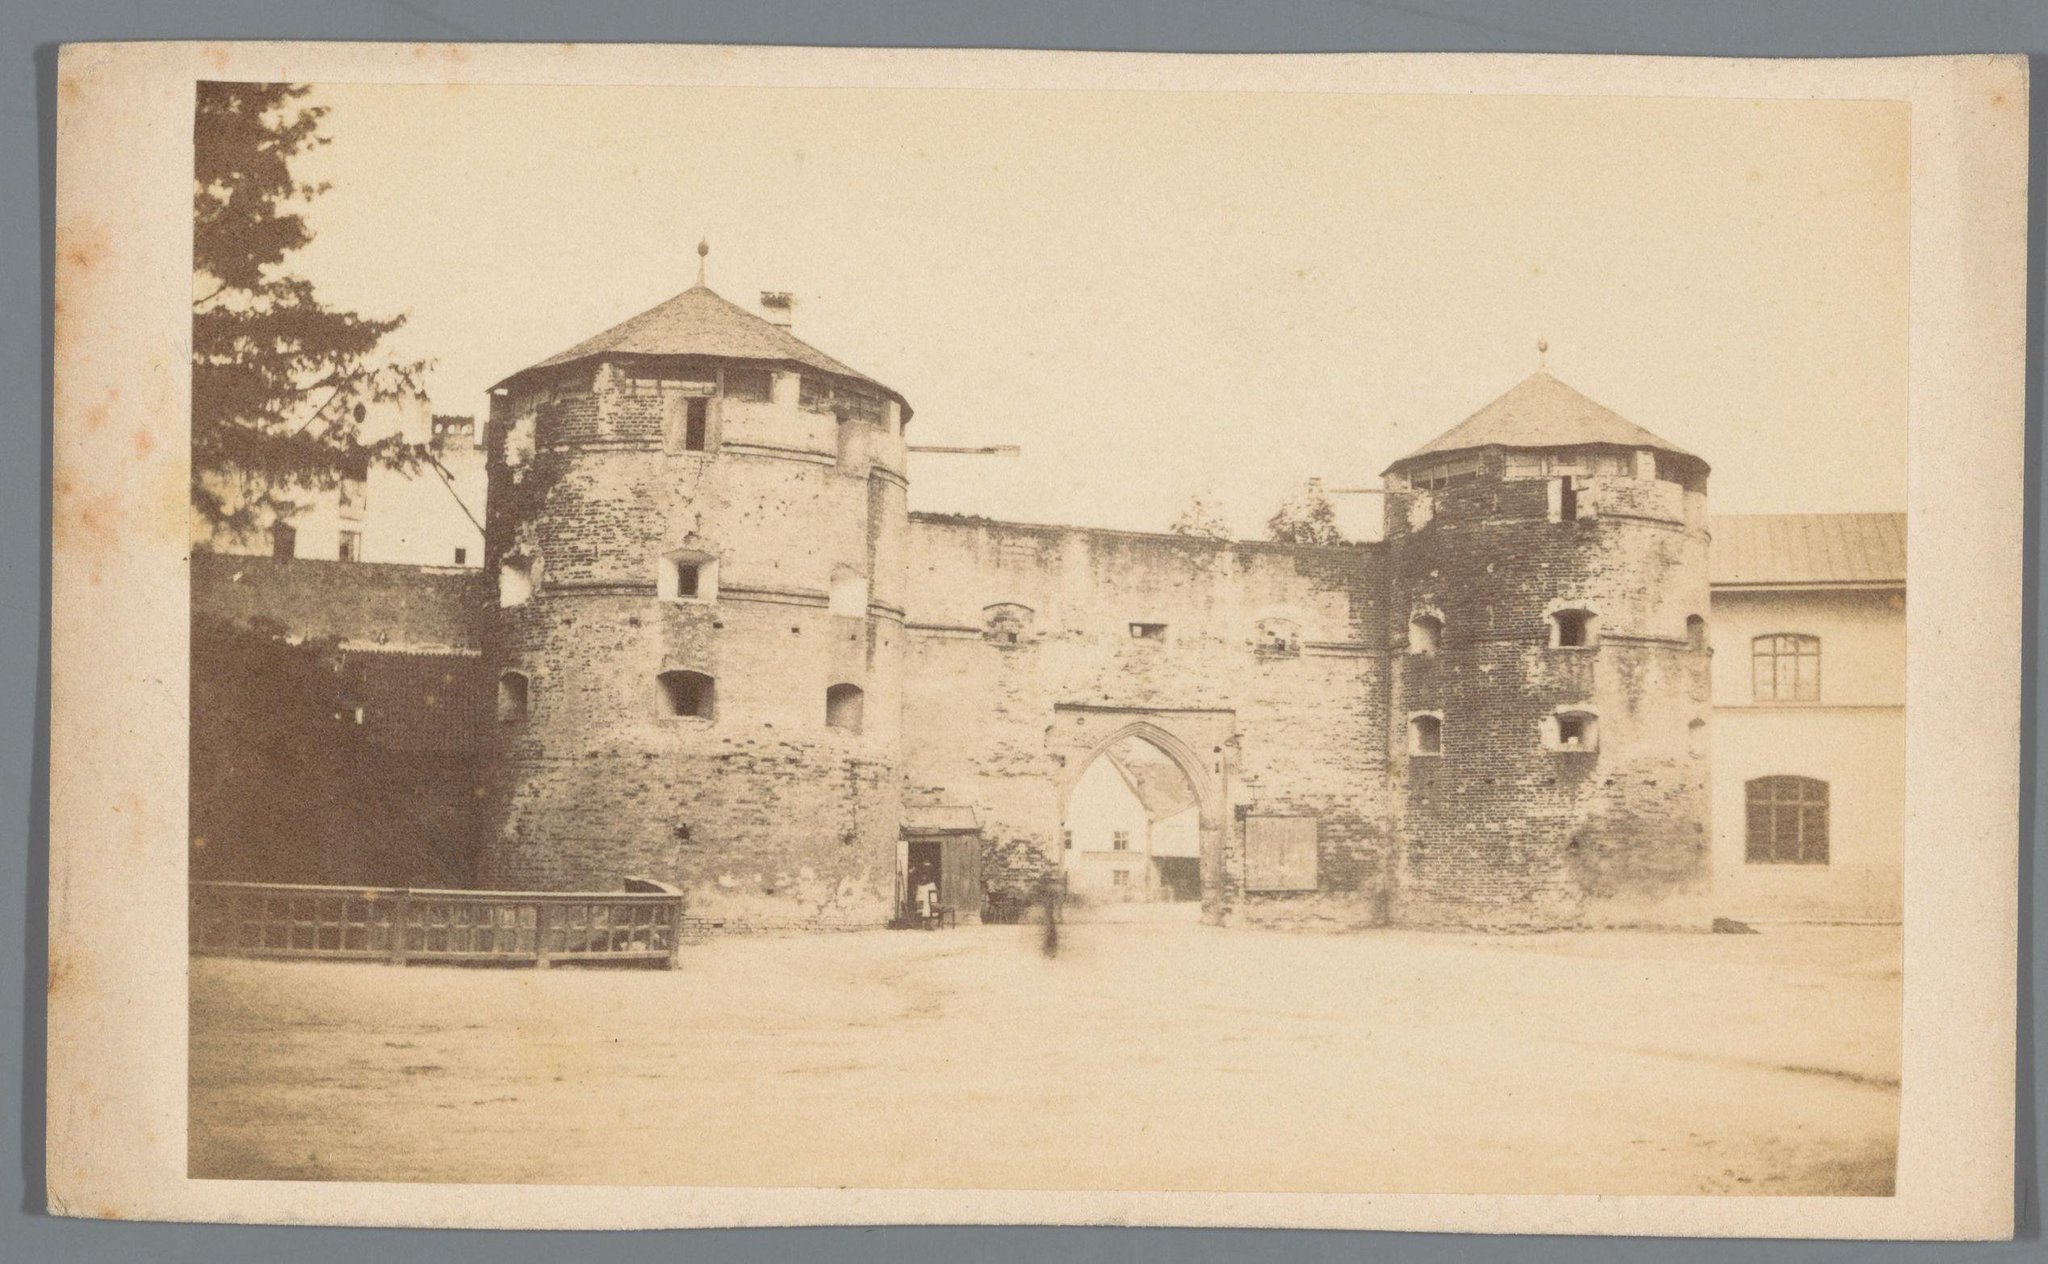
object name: photograph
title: Munchen, oude poort achter de Maximilan Strasse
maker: Anonymous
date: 1855-1885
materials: cardboard, paper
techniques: albumen print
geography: munich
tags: city-gate